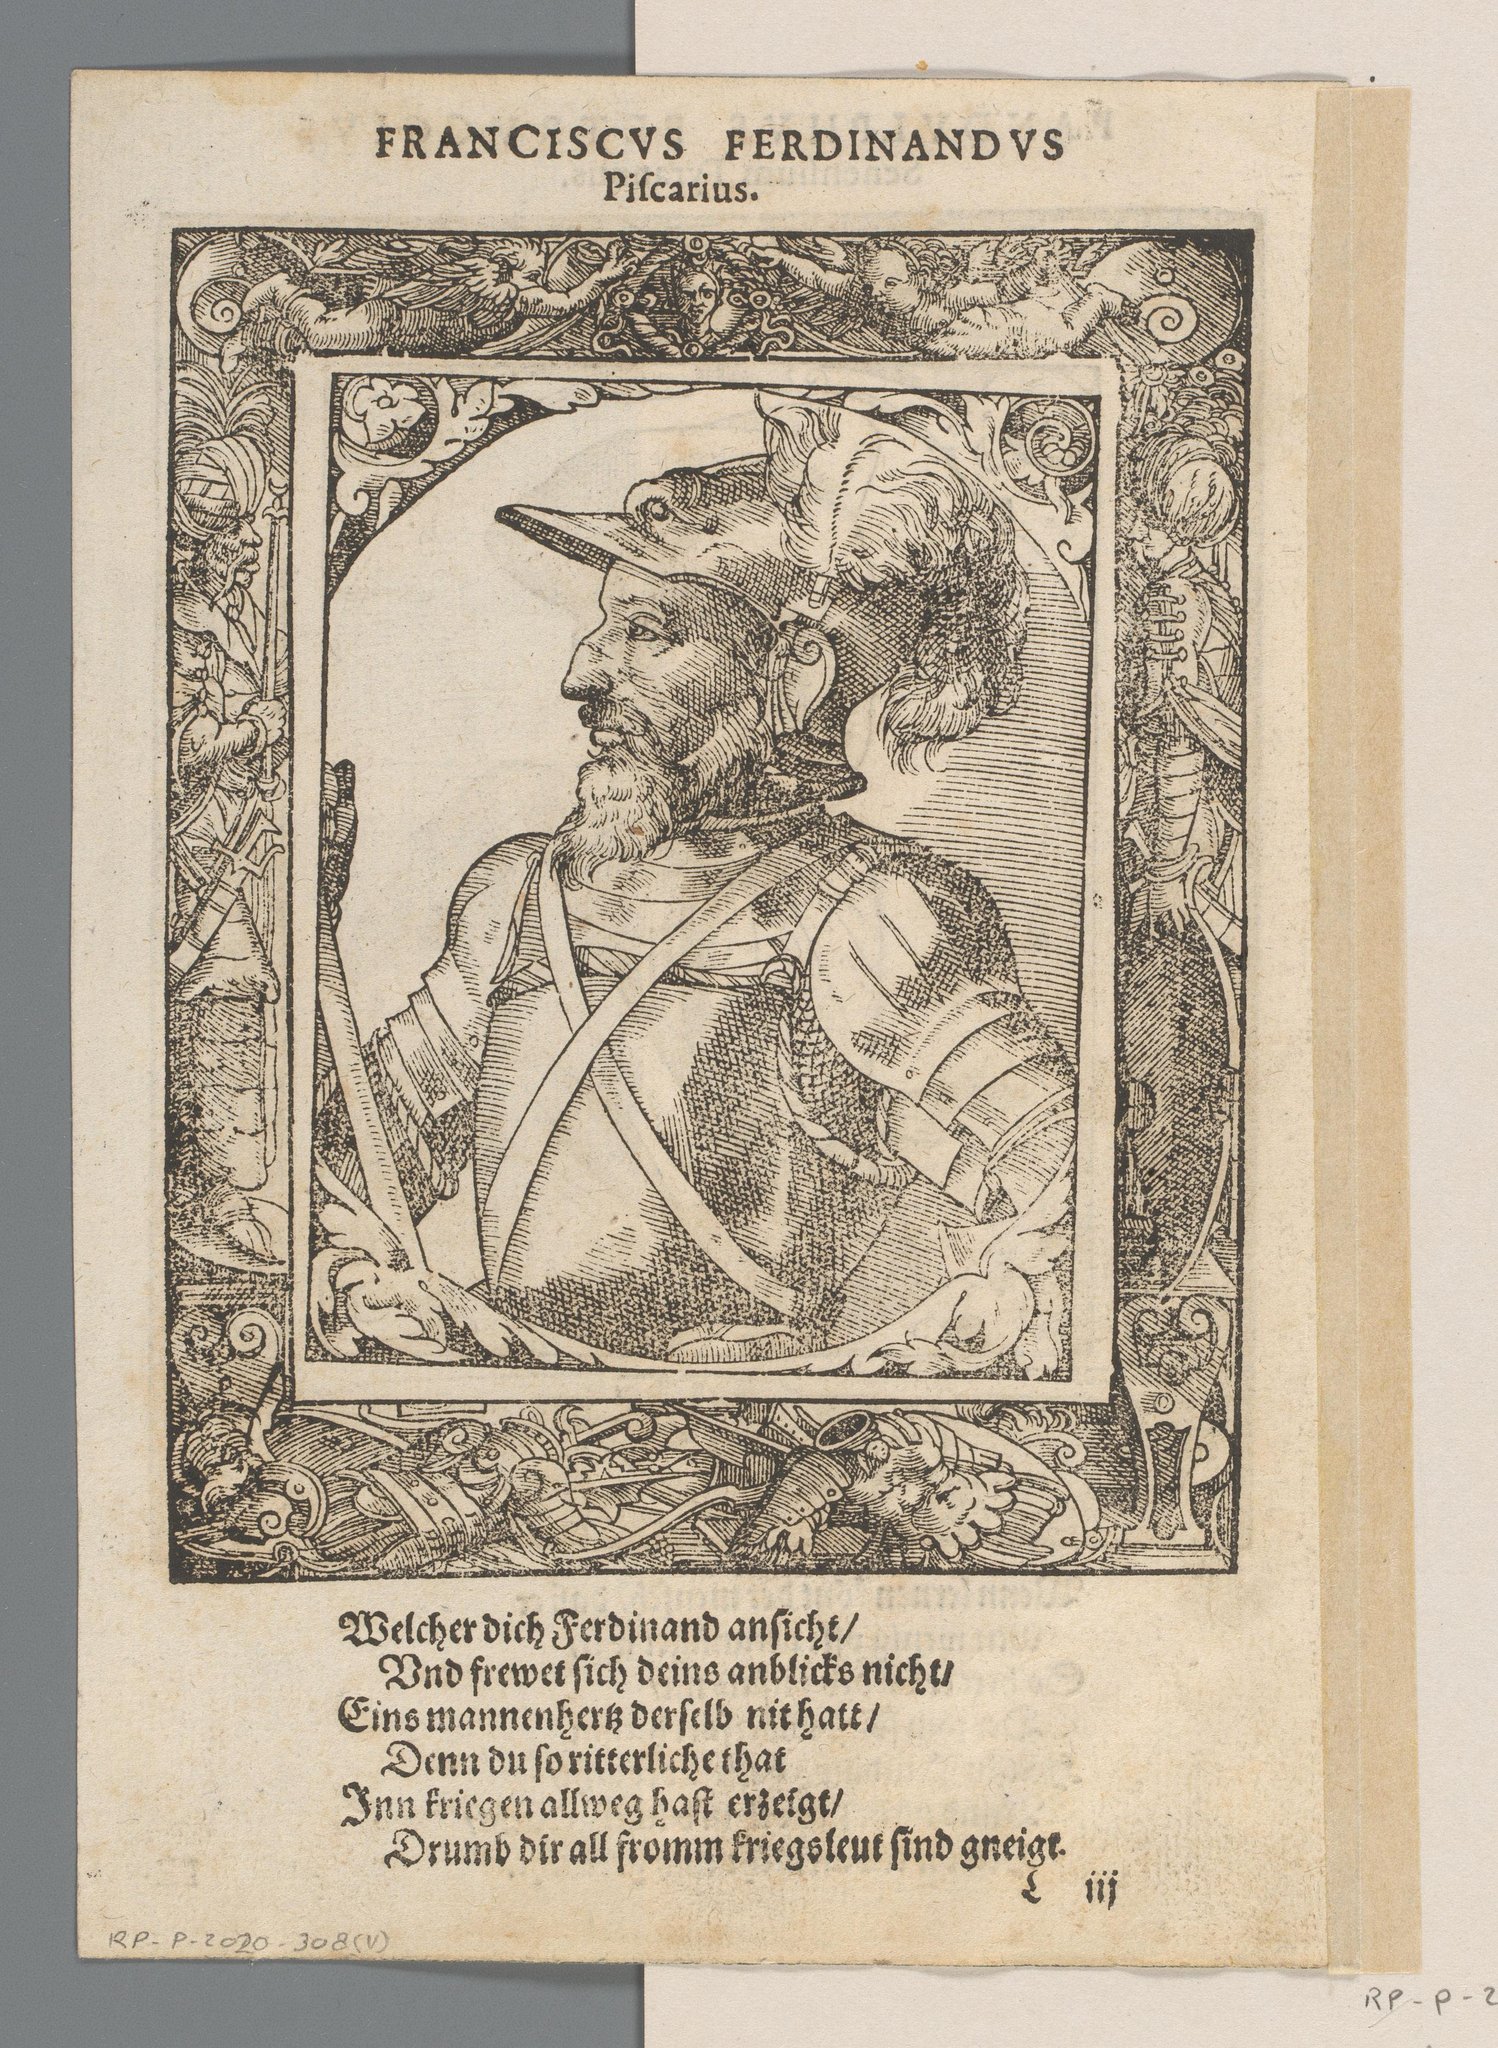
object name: book illustration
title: Portret van Fernando Francesco d'Avalos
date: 1577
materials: paper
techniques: letterpress printing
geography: basel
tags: naples, helmet, commander-in-chief, general, marshal, armour, historical persons, baton of general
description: Prent uit: Müller, Theobald. Eigentliche und gedenkwürdige Contrafacturen oder Anbildungen wolverdienter unnd Weitberümter Kriegshelden, (...). Bazel: Peter Perna, 1577. Prent eerder verschenen in: Giovio, Paolo. Elogia virorum bellica virtute illustrium (...). Bazel: Peter Perna, 1575. Prent ook gebruikt in latere publicaties.